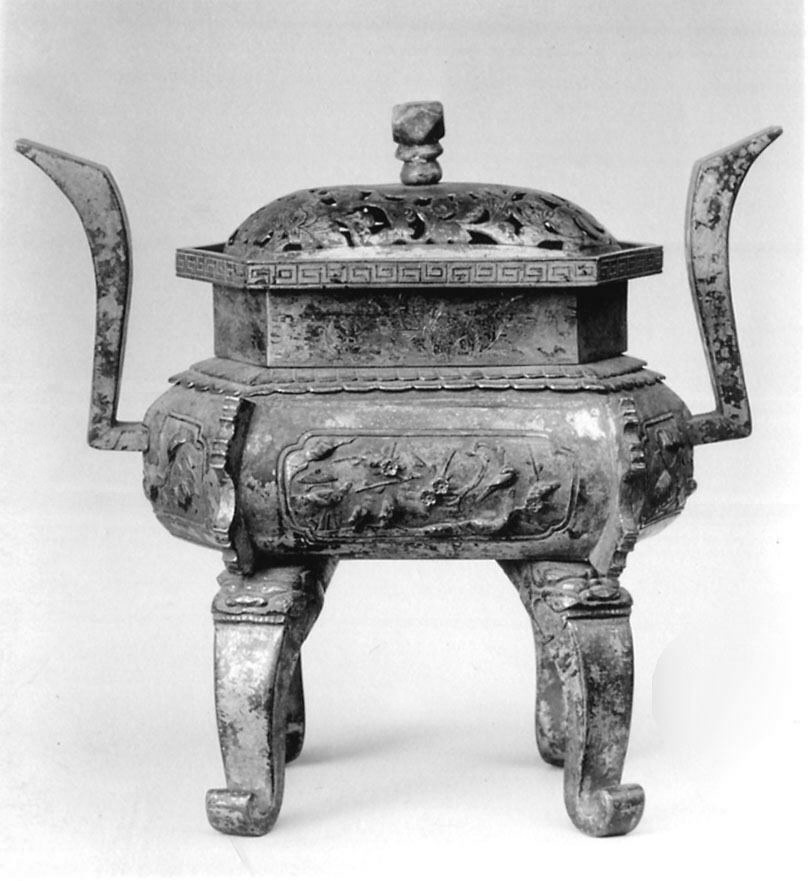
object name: incense burner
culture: chinese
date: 1368-1644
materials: gilt bronze